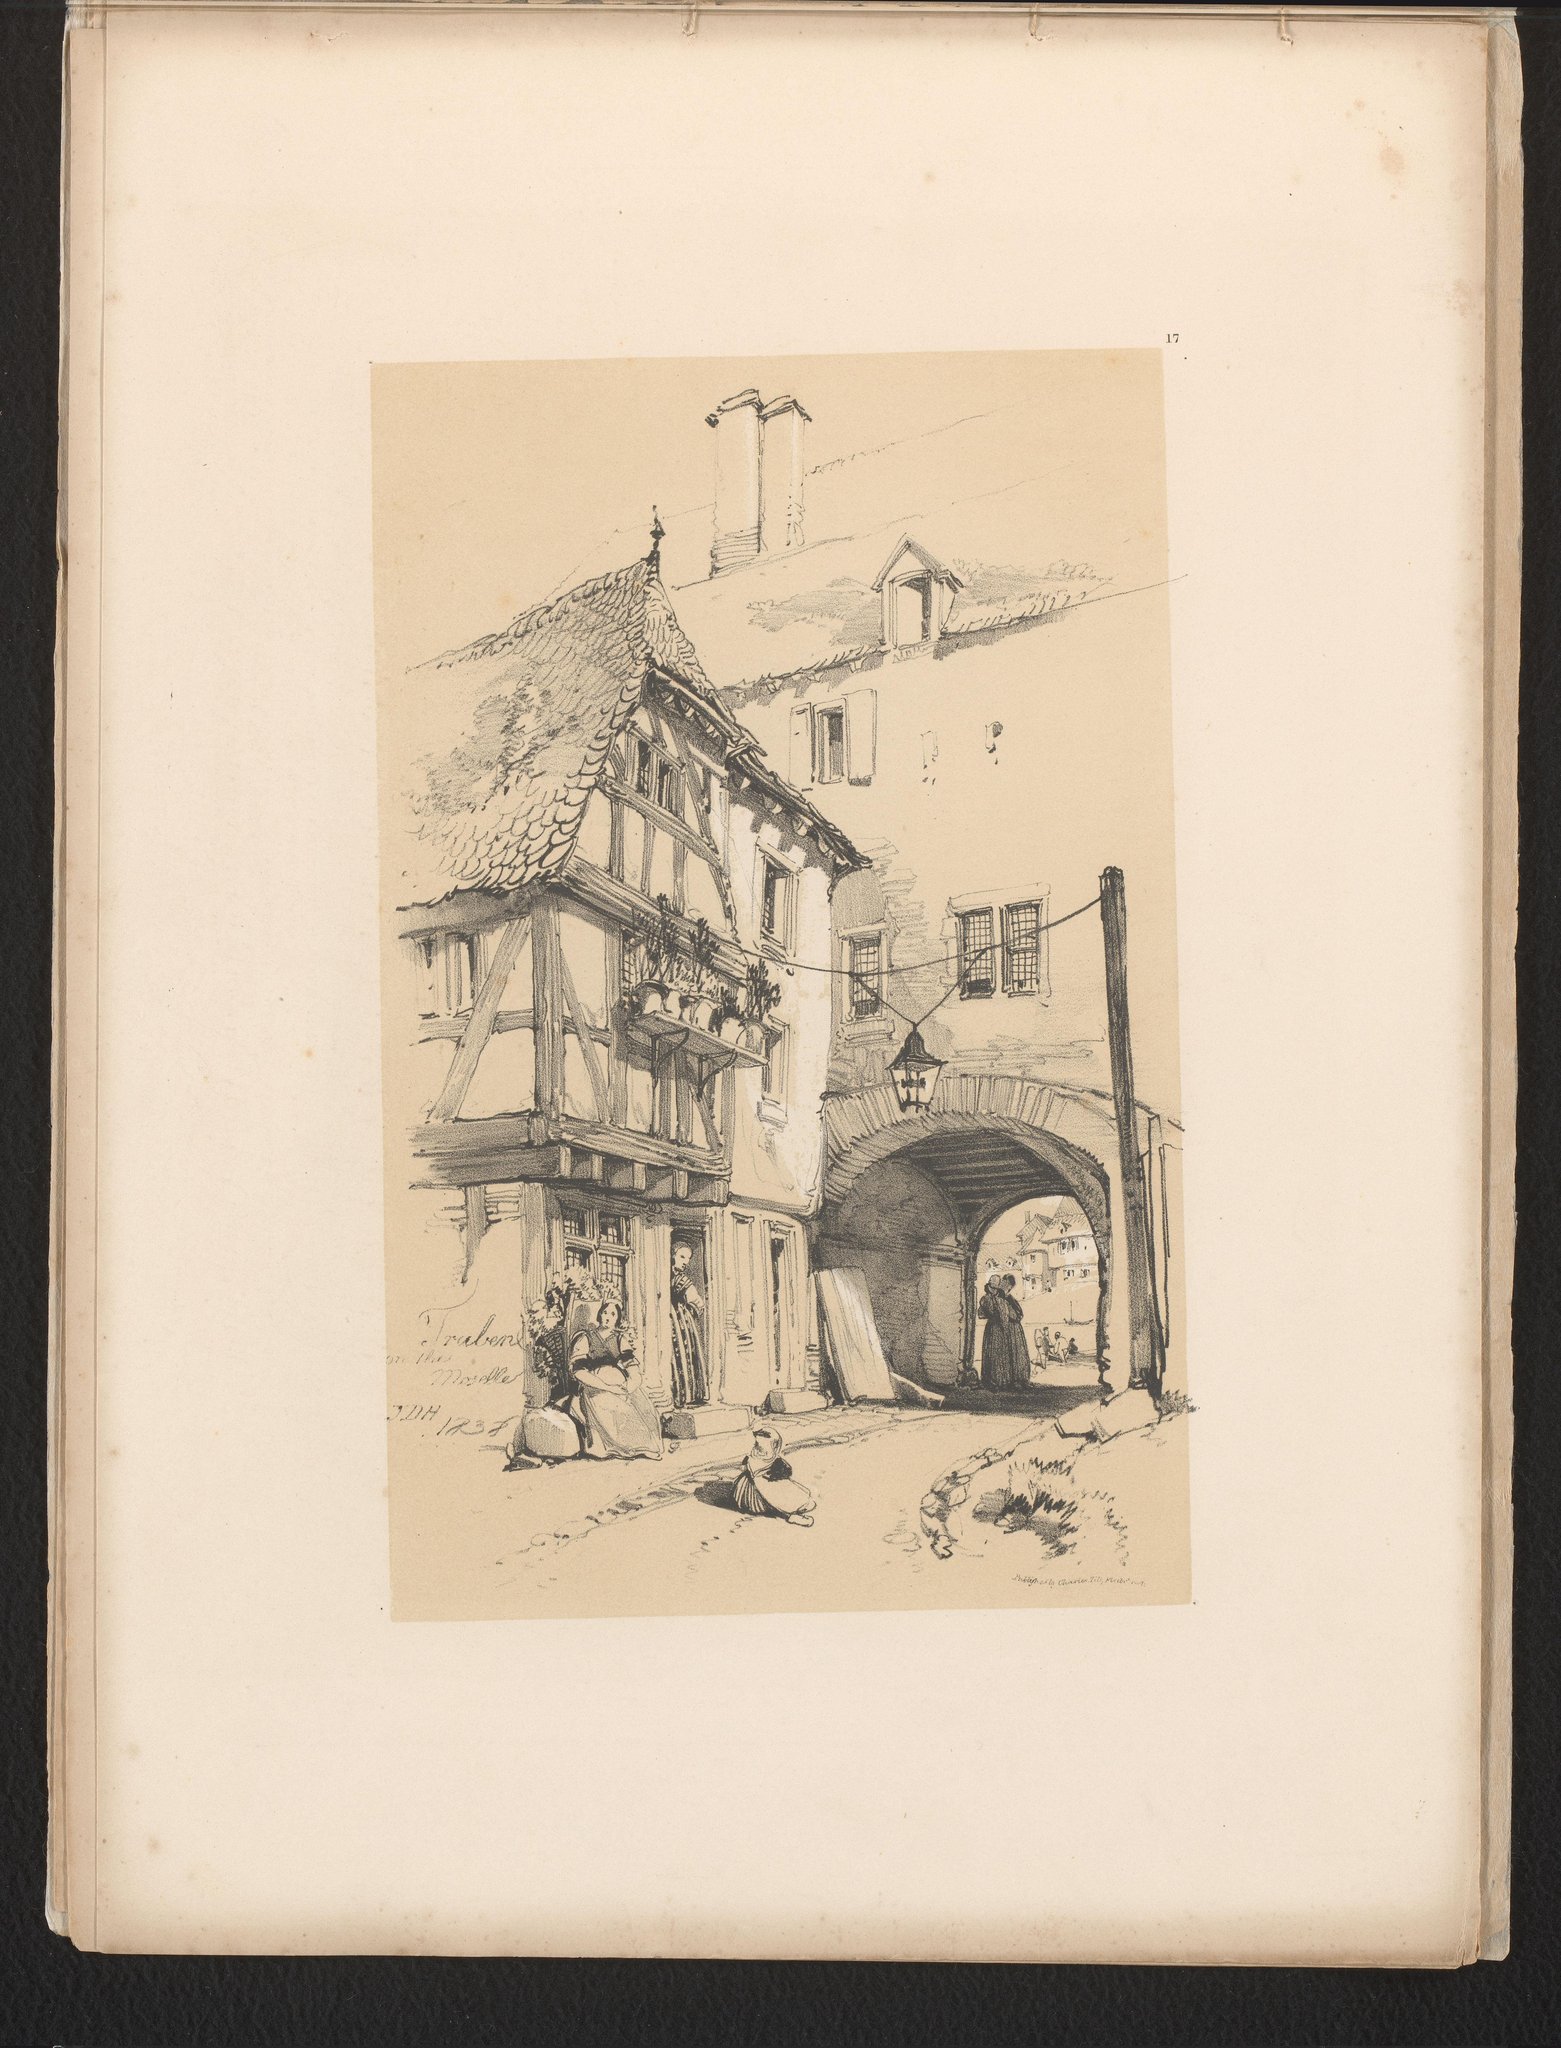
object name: print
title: Harding's drawing book for the year MDCCCXXXVIII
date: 1838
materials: paper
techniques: tone lithography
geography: london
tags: village street (+ city(-scape) with figures, staffage)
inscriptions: collector's mark: Lugt 2228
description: Uitgever Charles Tilt heeft verschillende series uitgegeven over het werk van James Duffield Harding. Deze serie 'Harding's drawing book for the year MDCCCXXXVIII', bestaat uit zes delen met elk vier lithografieën.